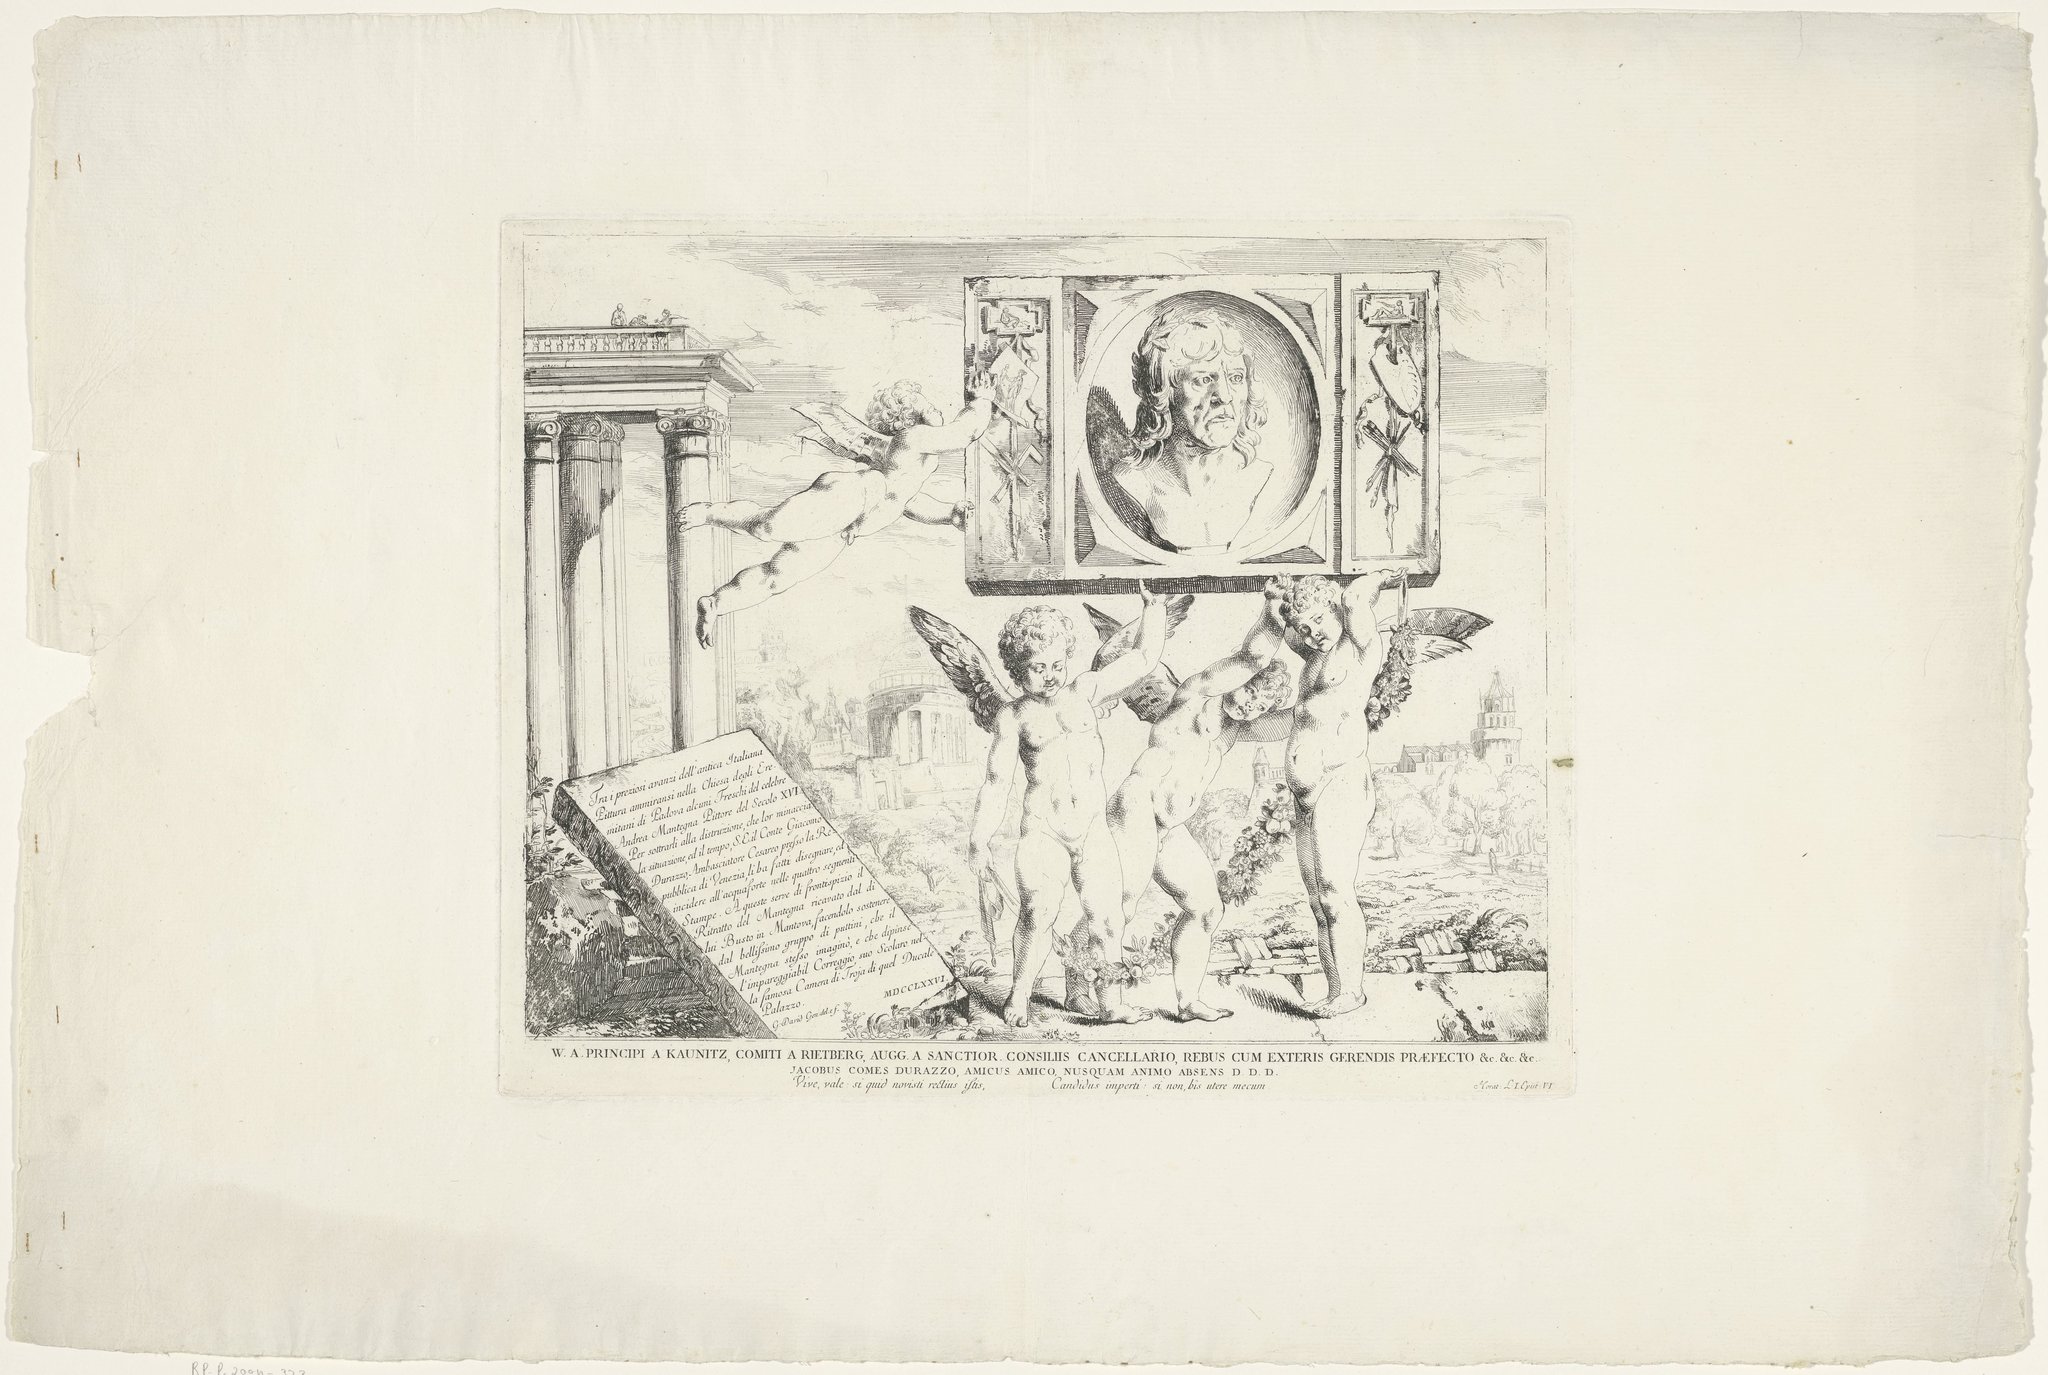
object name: titelprent, frontispice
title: De fresco's van Andrea Mantegna in de Chiesa degli Eremitani in Padua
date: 1776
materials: paper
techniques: etching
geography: italy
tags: andrea mantegna, tools, implements of painter, portrait, self-portrait of artist, cupids: 'amores', 'amoretti', 'putti'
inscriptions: collector's mark: Lugt 2228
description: Titelblad bij een reeks van vier prenten met weergaven van de fresco's van Andrea Mantegna in de Chiesa degli Eremitani in Padua (fresco's zijn vernietigd tijdens bombardement 11 maart 1944). David maakte de prentreeks naar de in 18de eeuw al door luchtvervuiling bedreigde fresco's in opdracht van graaf Jacobi Durazzo. Deze titelprent is zelf geen contra-épreuve, maar gaat vooraf aan reeks van unieke(?) contra-épreuves in het RPK, die Mantegna's voorstellingen in dezelfde richting weergeven. Het titelblad werd waarschijnlijk niet als contra-épreuve gedrukt vanwege de leesbaarheid van de uitvoerige opschriften. Het portret van Mantegna is ontleend aan de bronzen buste van de kunstenaar in de Sant'Andrea te Mantova en de putti aan het fresco in de Camera degli Sposi.